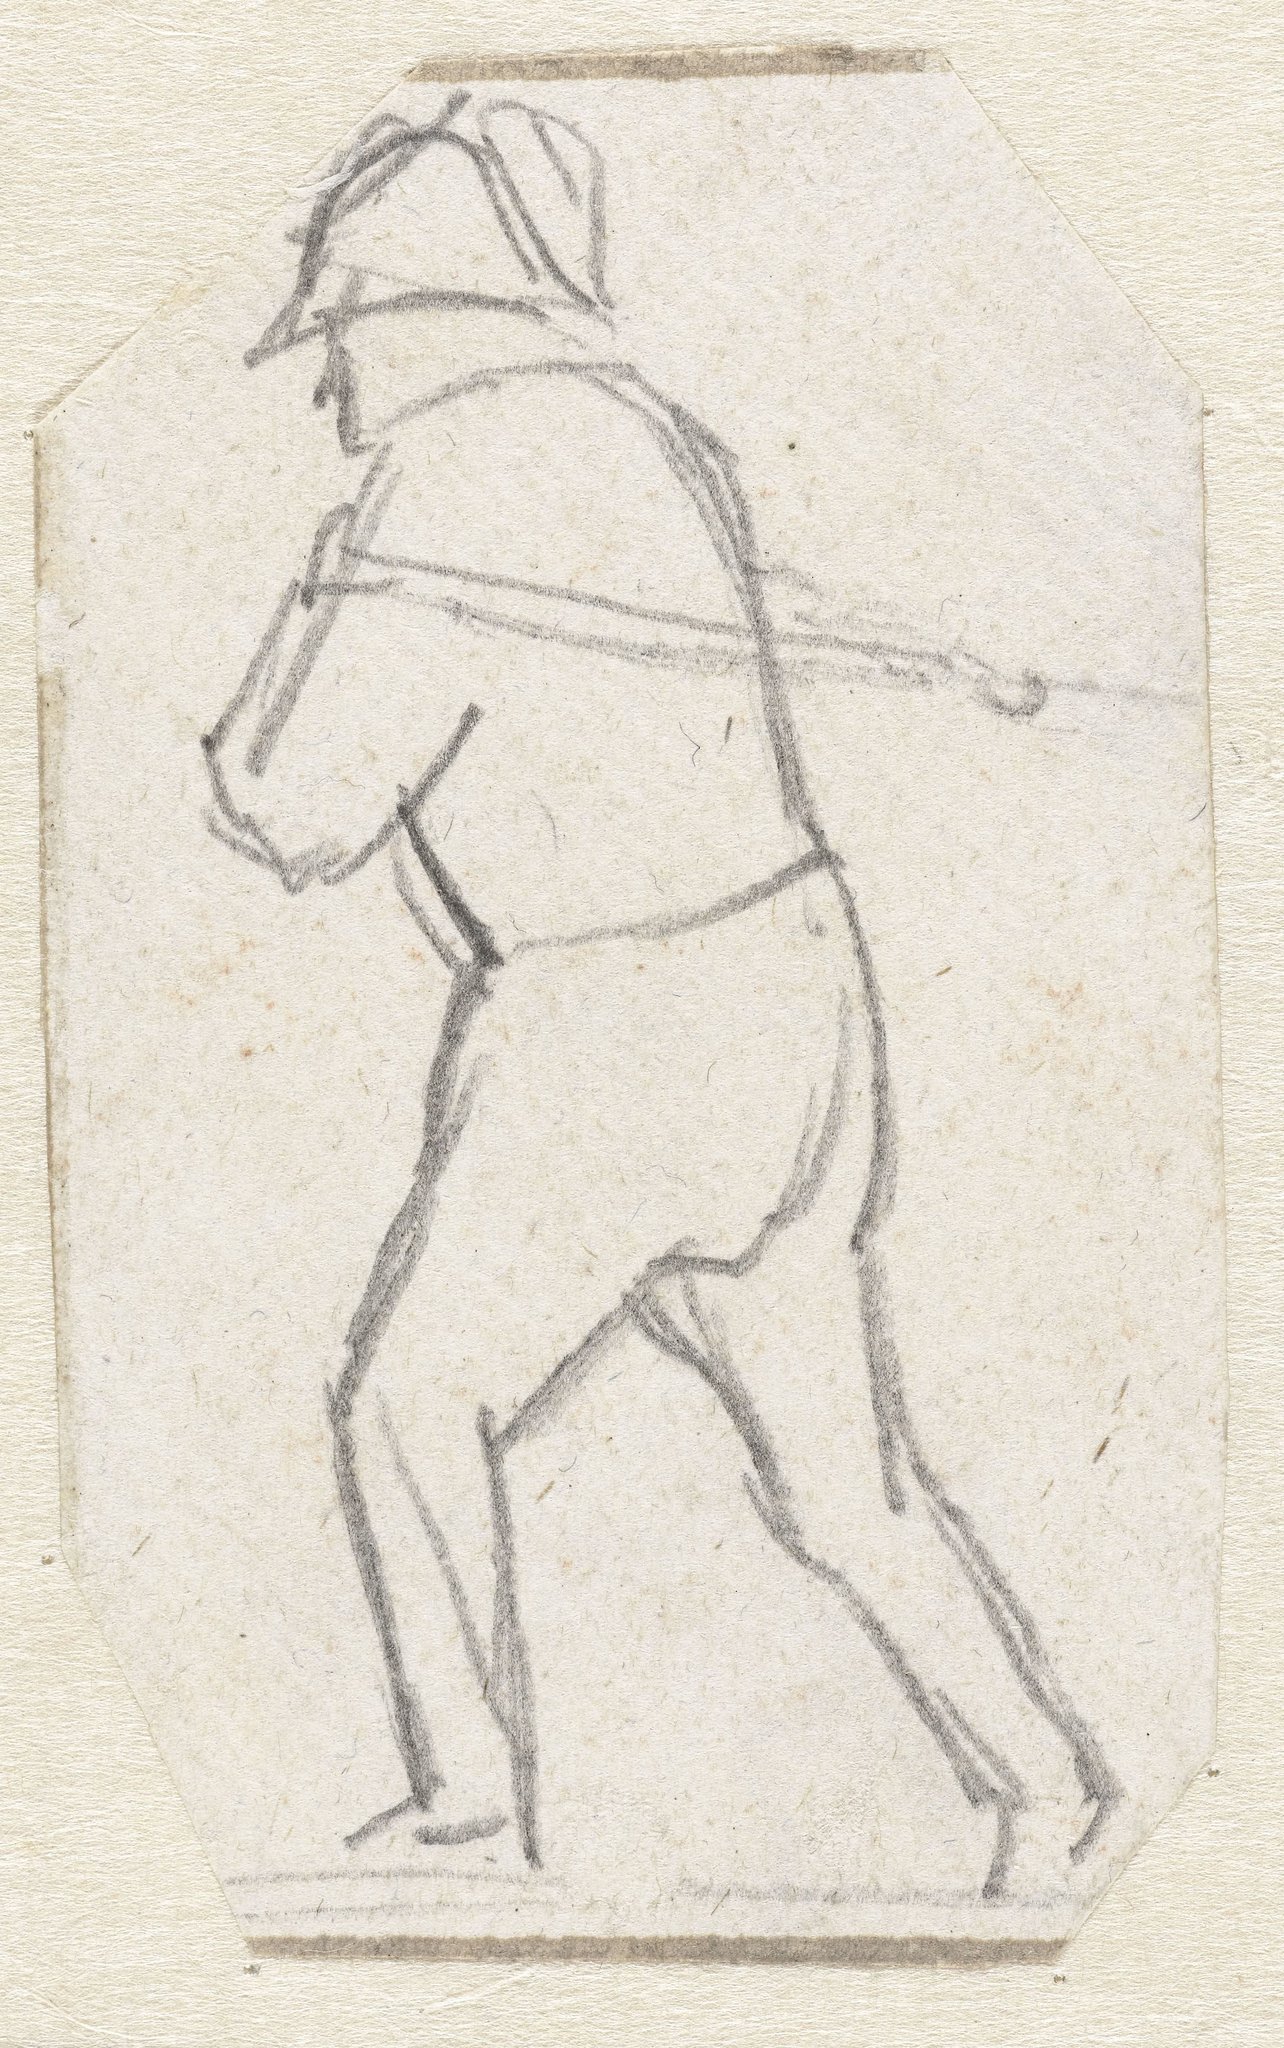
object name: drawing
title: Jagertje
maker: simon andreas krausz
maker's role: draughtsman, print maker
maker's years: 1760-1825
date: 1770-1825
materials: paper, pencil